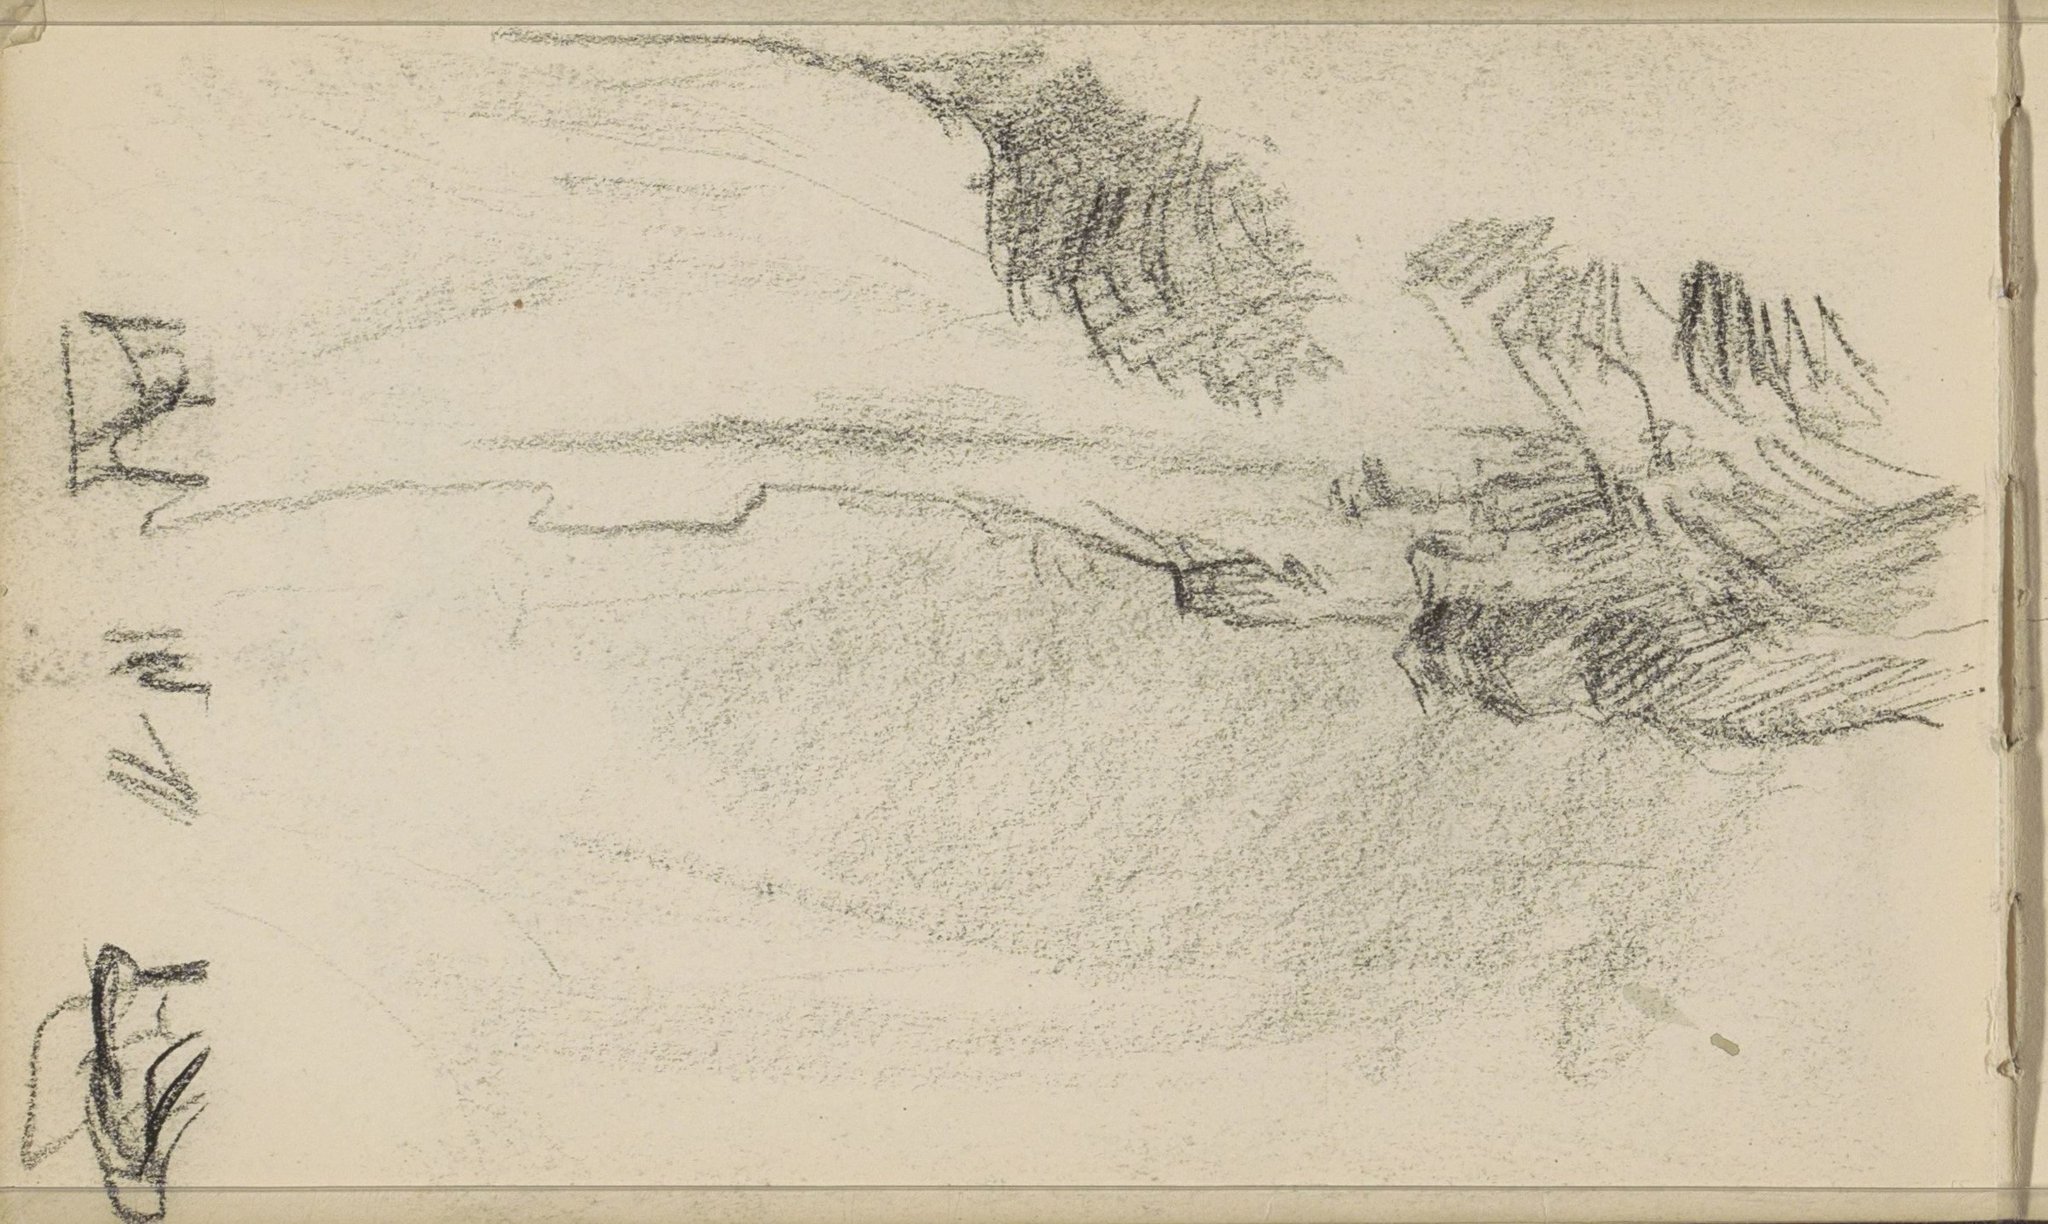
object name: sketchbook leaf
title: Duinlandschap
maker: johan antonie de jonge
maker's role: draughtsman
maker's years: 1864-1927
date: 1901-1927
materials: chalk, paper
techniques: stumping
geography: south holland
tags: dunes (sea not visible); in the dunes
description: Duinlandschap. Blad 41 verso uit een schetsboek met 45 bladen.